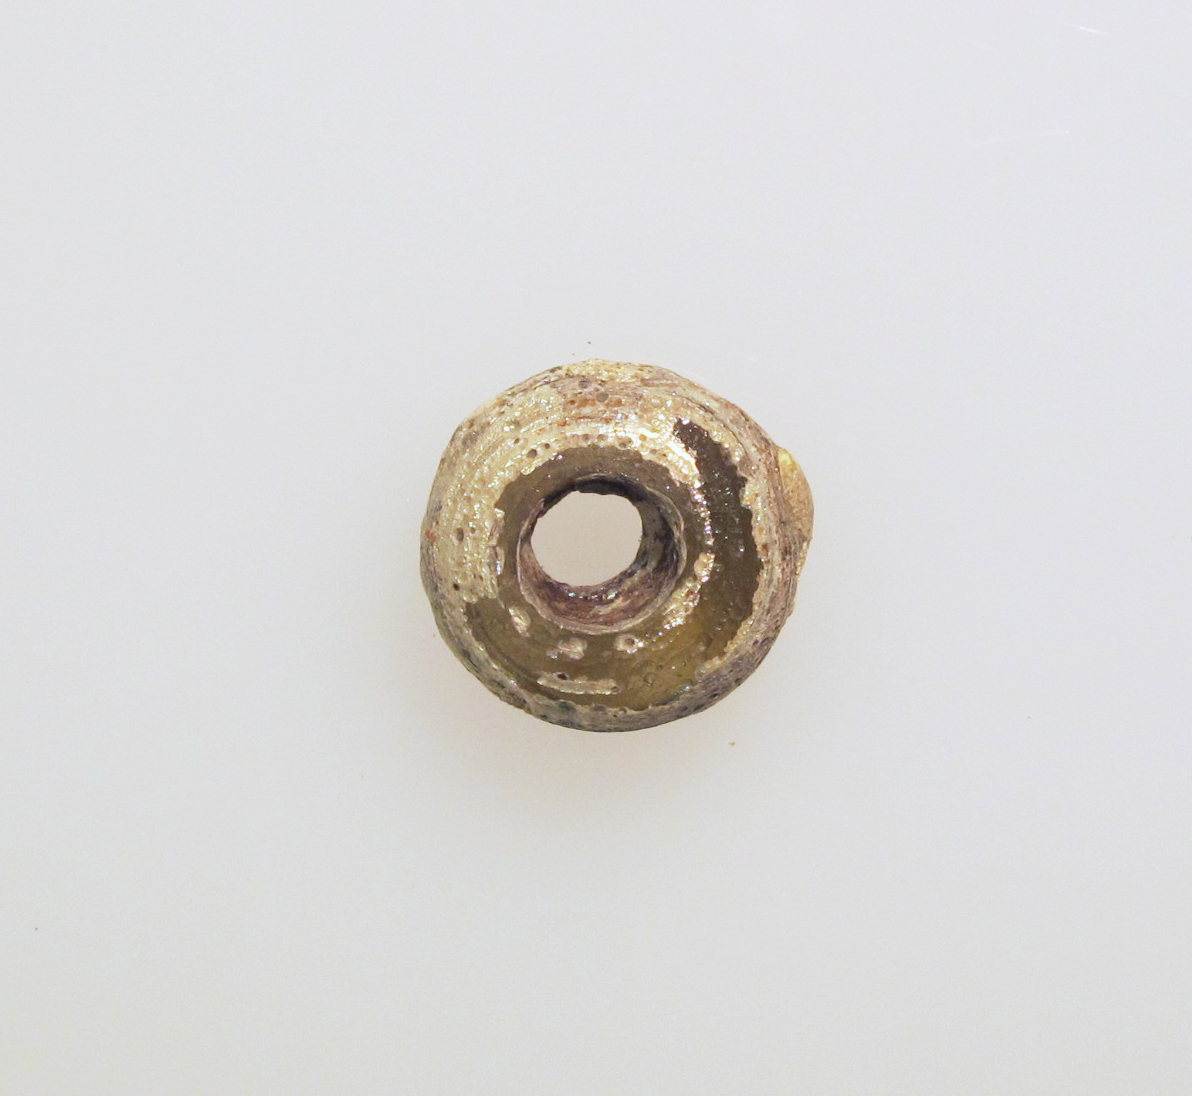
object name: bead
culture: roman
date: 670 BCE-330 CE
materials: glass